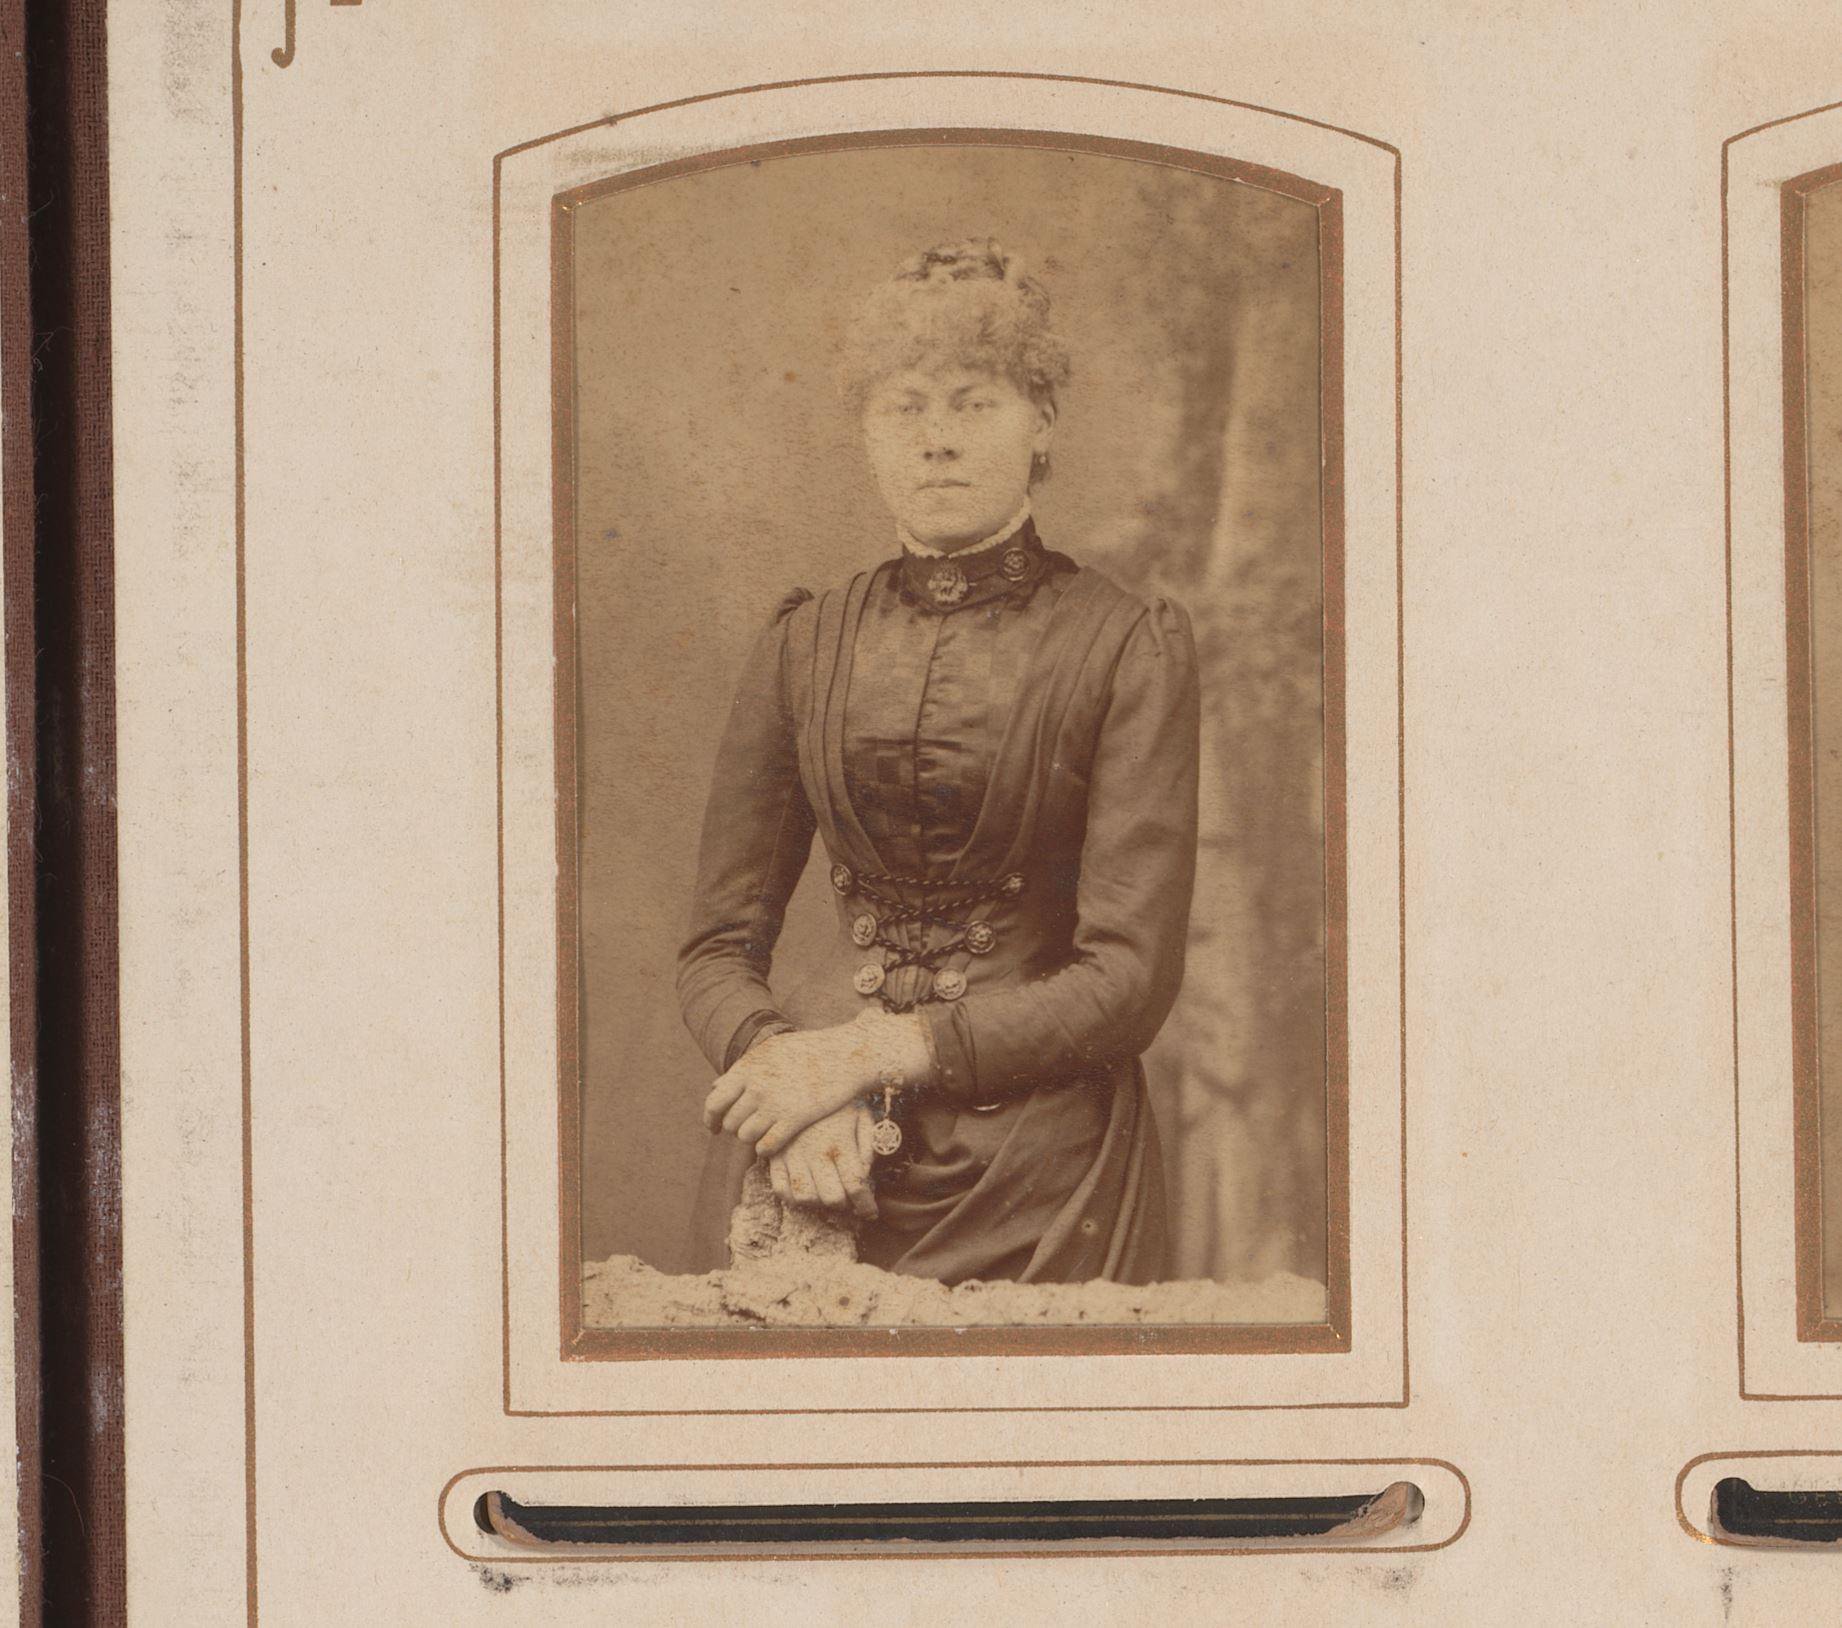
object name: album leaf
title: Portret van een vrouw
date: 1864-1886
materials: cardboard, photographic support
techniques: albumen print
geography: the hague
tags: historical persons - bb - woman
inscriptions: inscription: ‘Gebr. Delboy/ Den Haag’